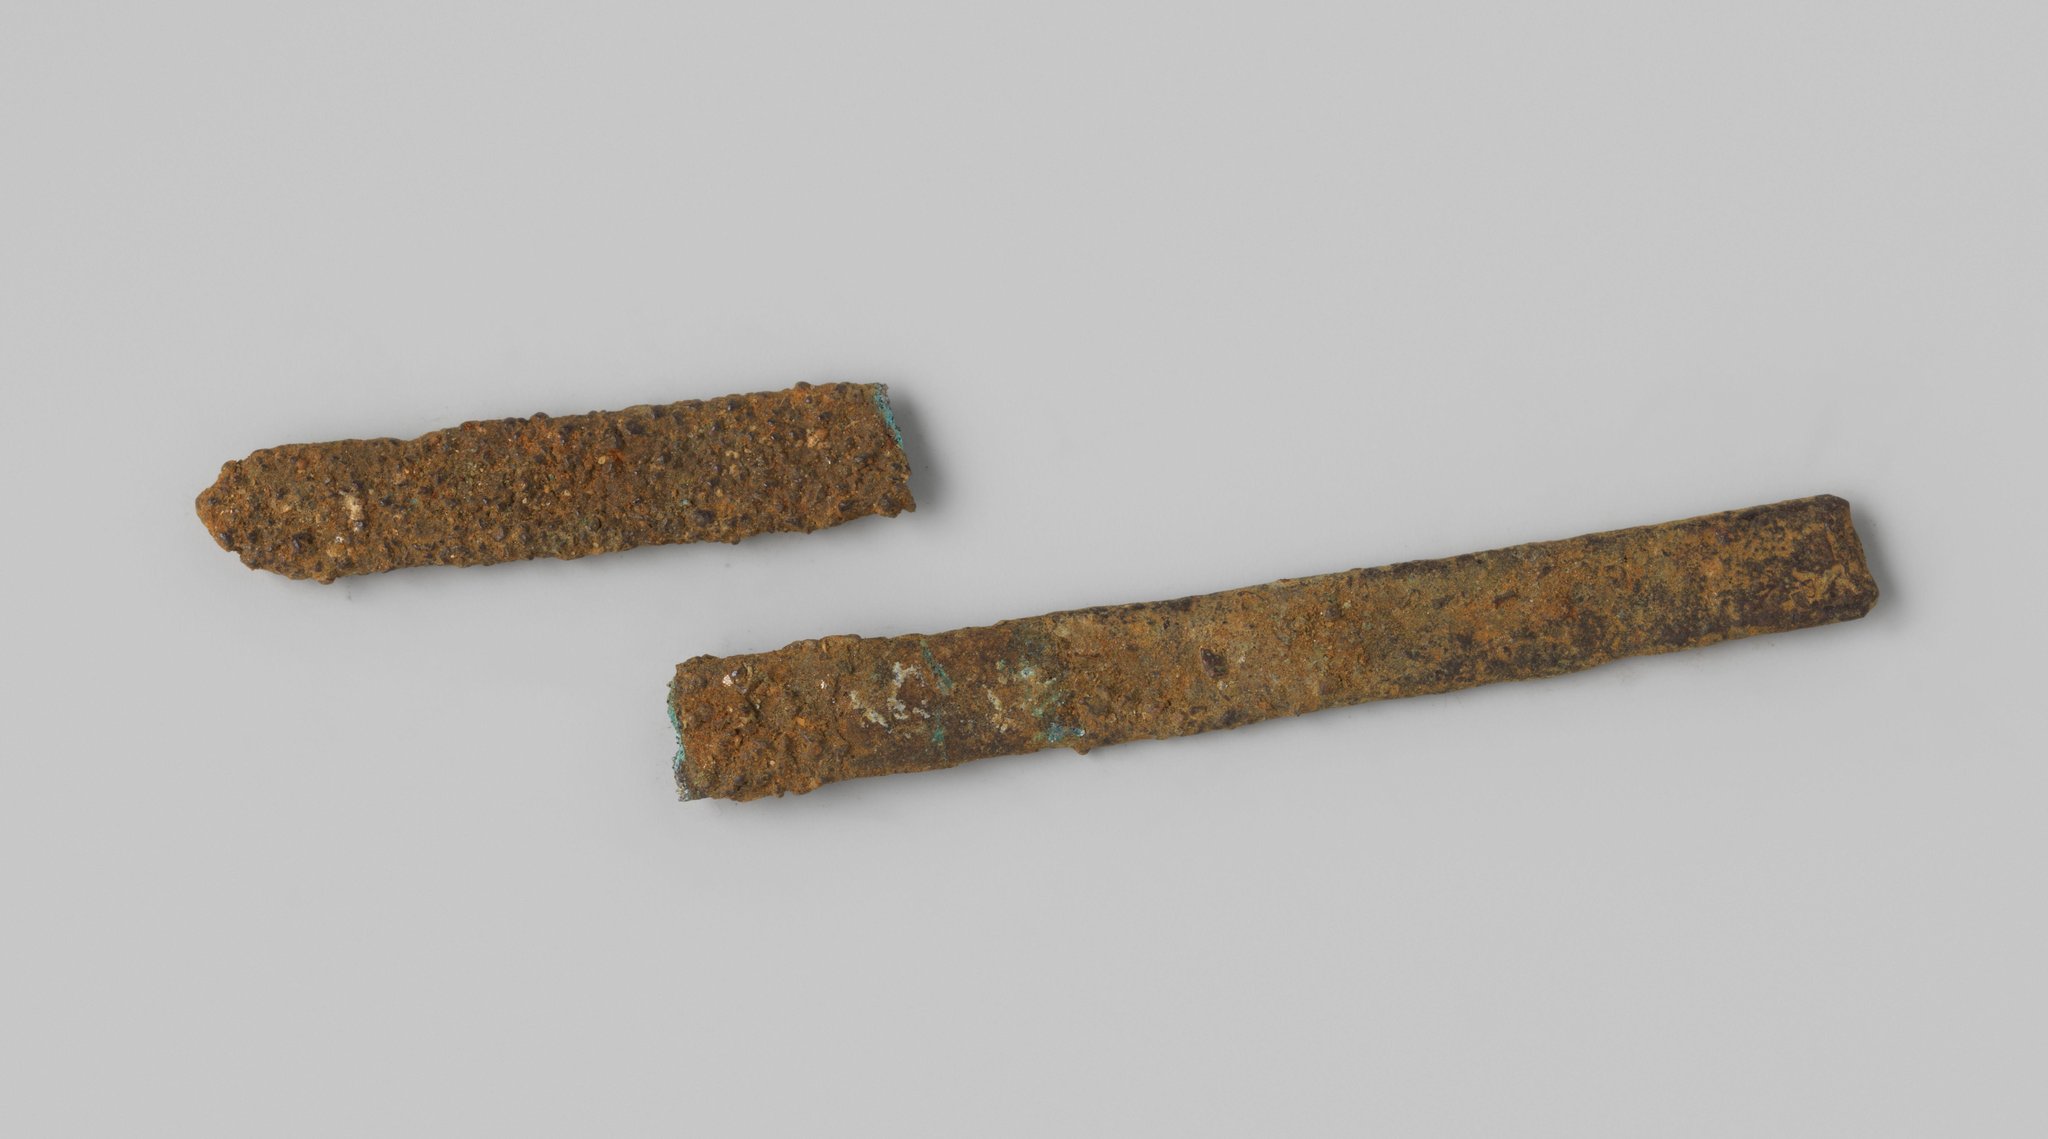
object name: belt buckle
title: Fragmenten riemgesp uit het wrak van de Oost-Indiëvaarder Hollandia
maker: Anonymous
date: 1700-1743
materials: copper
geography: netherlands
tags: verenigde oostindische compagnie, hollandia (schip), annet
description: Rectangular, fragm of ring, id. NG 1980-27H2852, belt buckle.